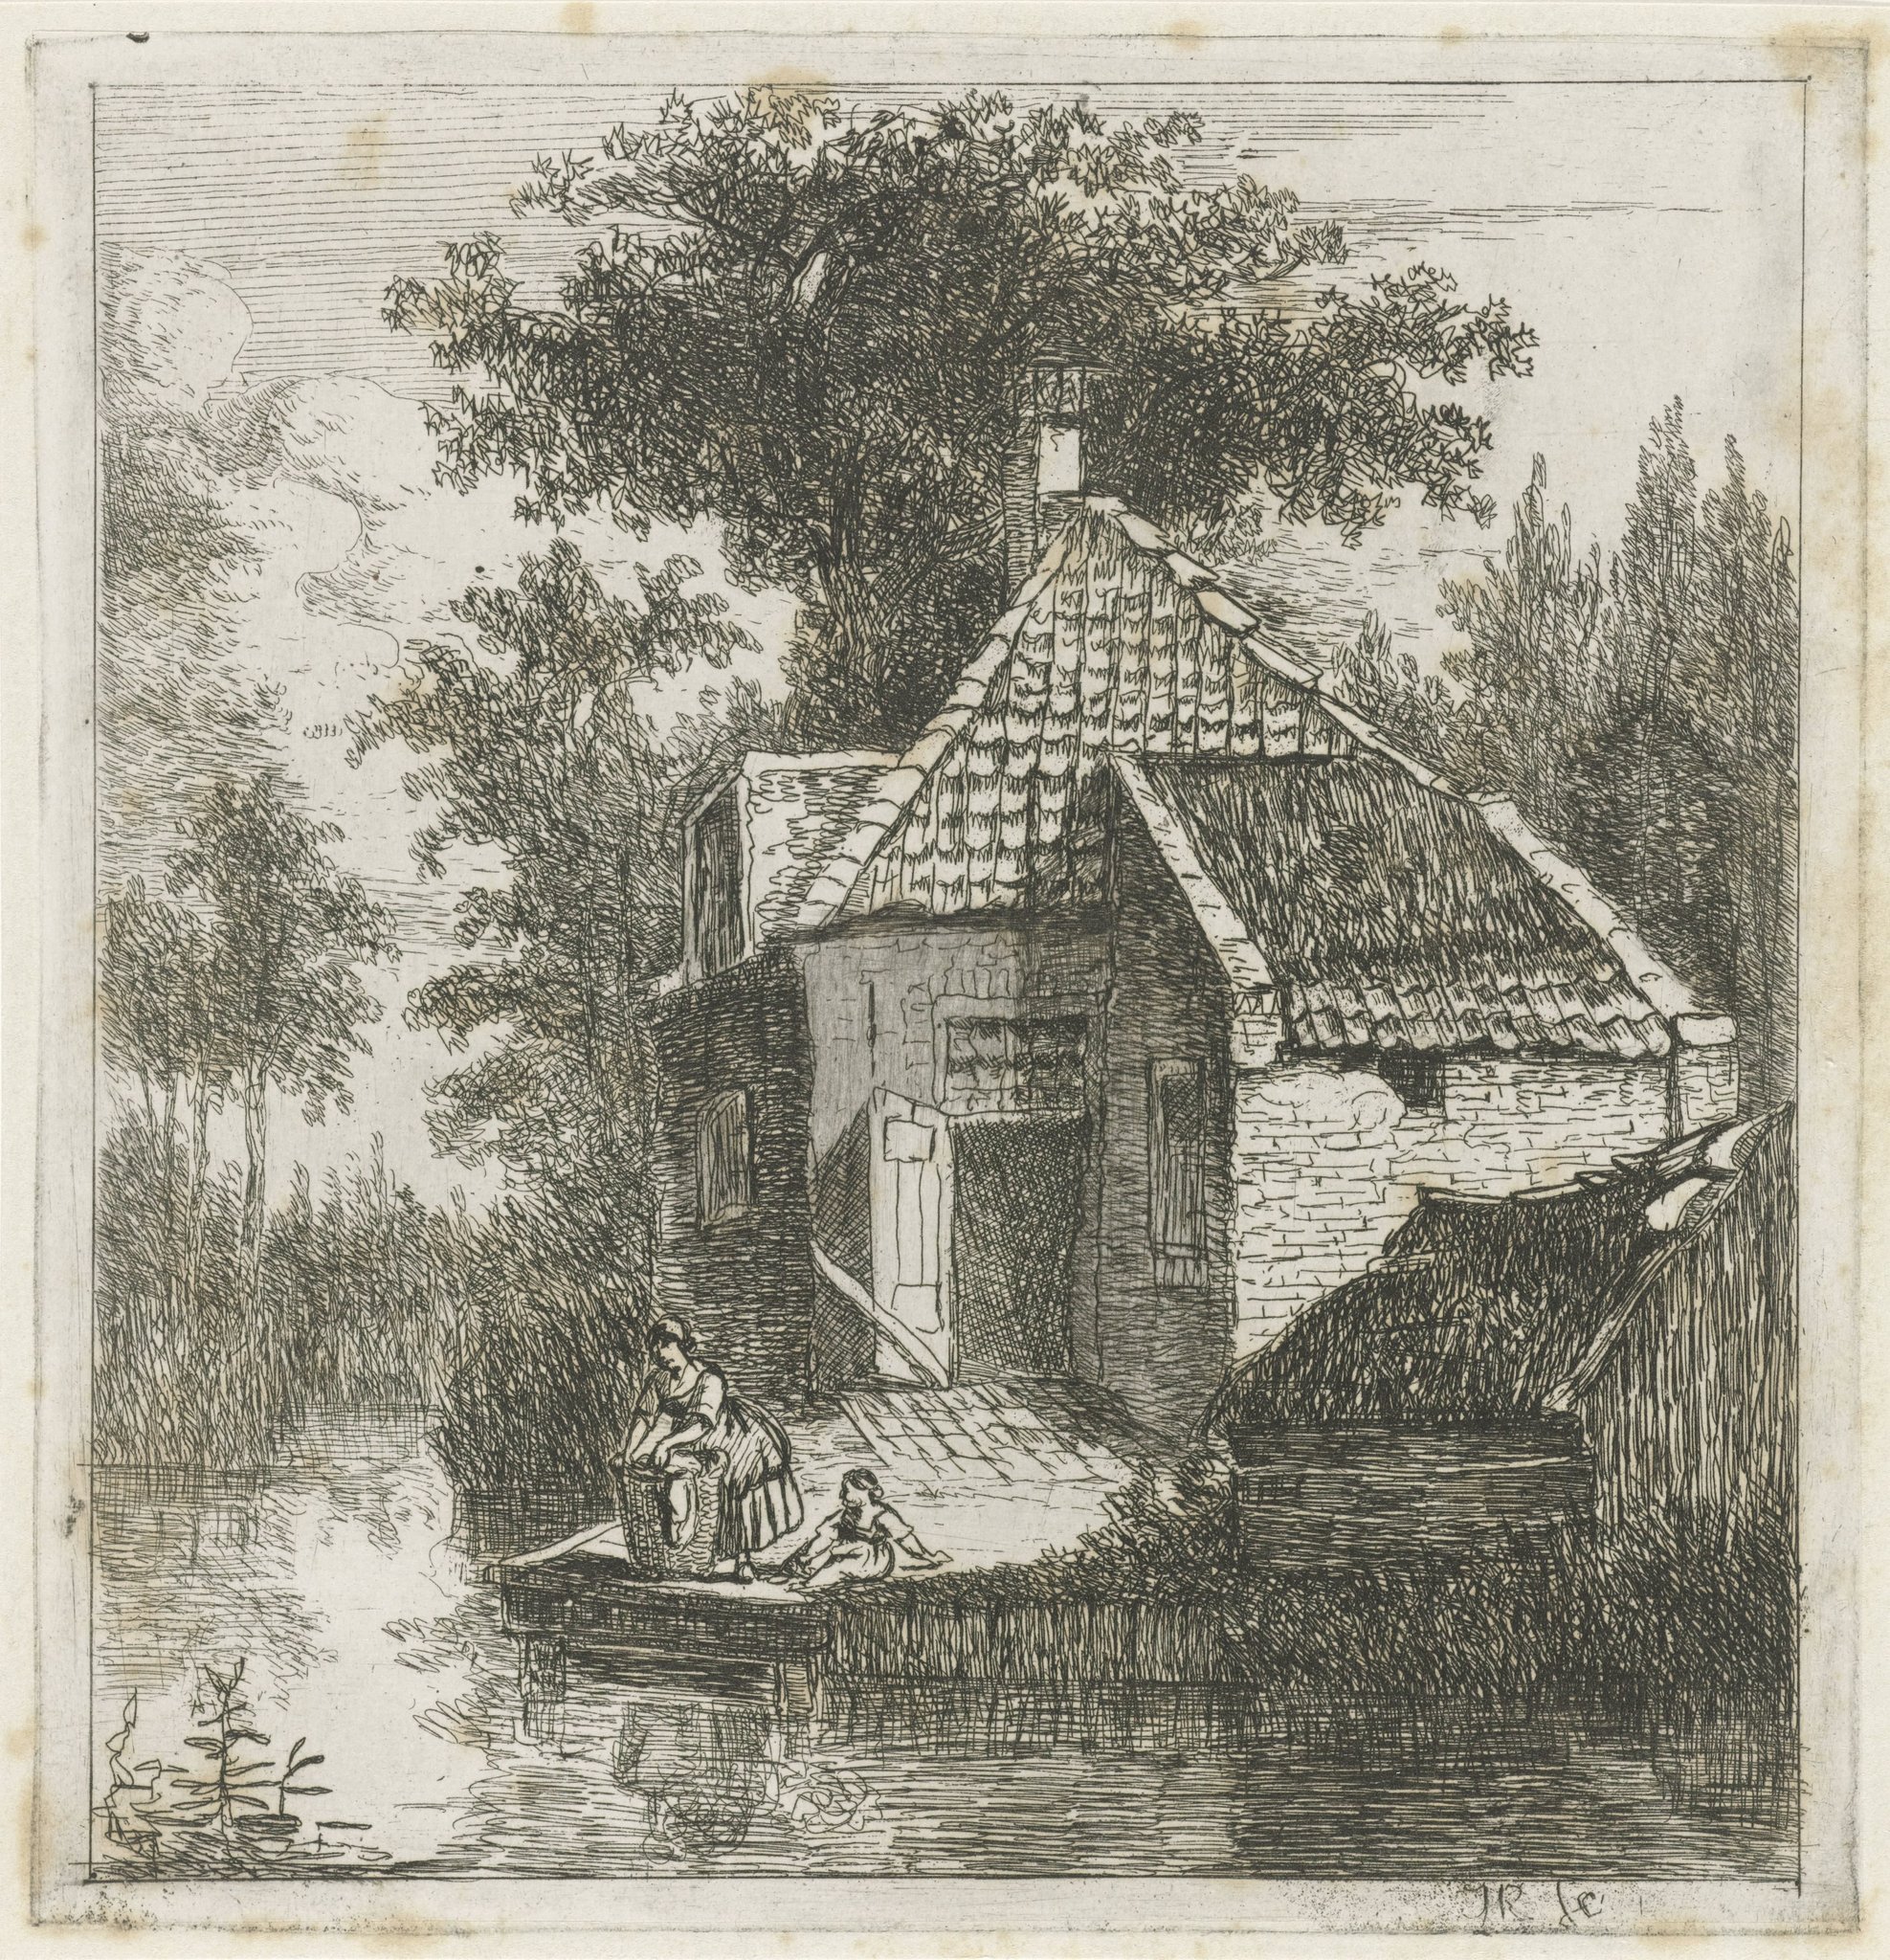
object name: print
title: Vrouw met een wasmand en een kind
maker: hermanus jan hendrik van rijkelijkhuysen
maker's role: painter, print maker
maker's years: 1813-1883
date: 1823-1883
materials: paper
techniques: drypoint, etching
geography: utrecht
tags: brook, laundering, mother and baby or young child, farm or solitary house in landscape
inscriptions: collector's mark: Lugt 2228, collector's mark: Lugt 1485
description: Voor een aan het water gelegen huis staat een vrouw met een wasmand op een steiger. Naast haar zit een kind.